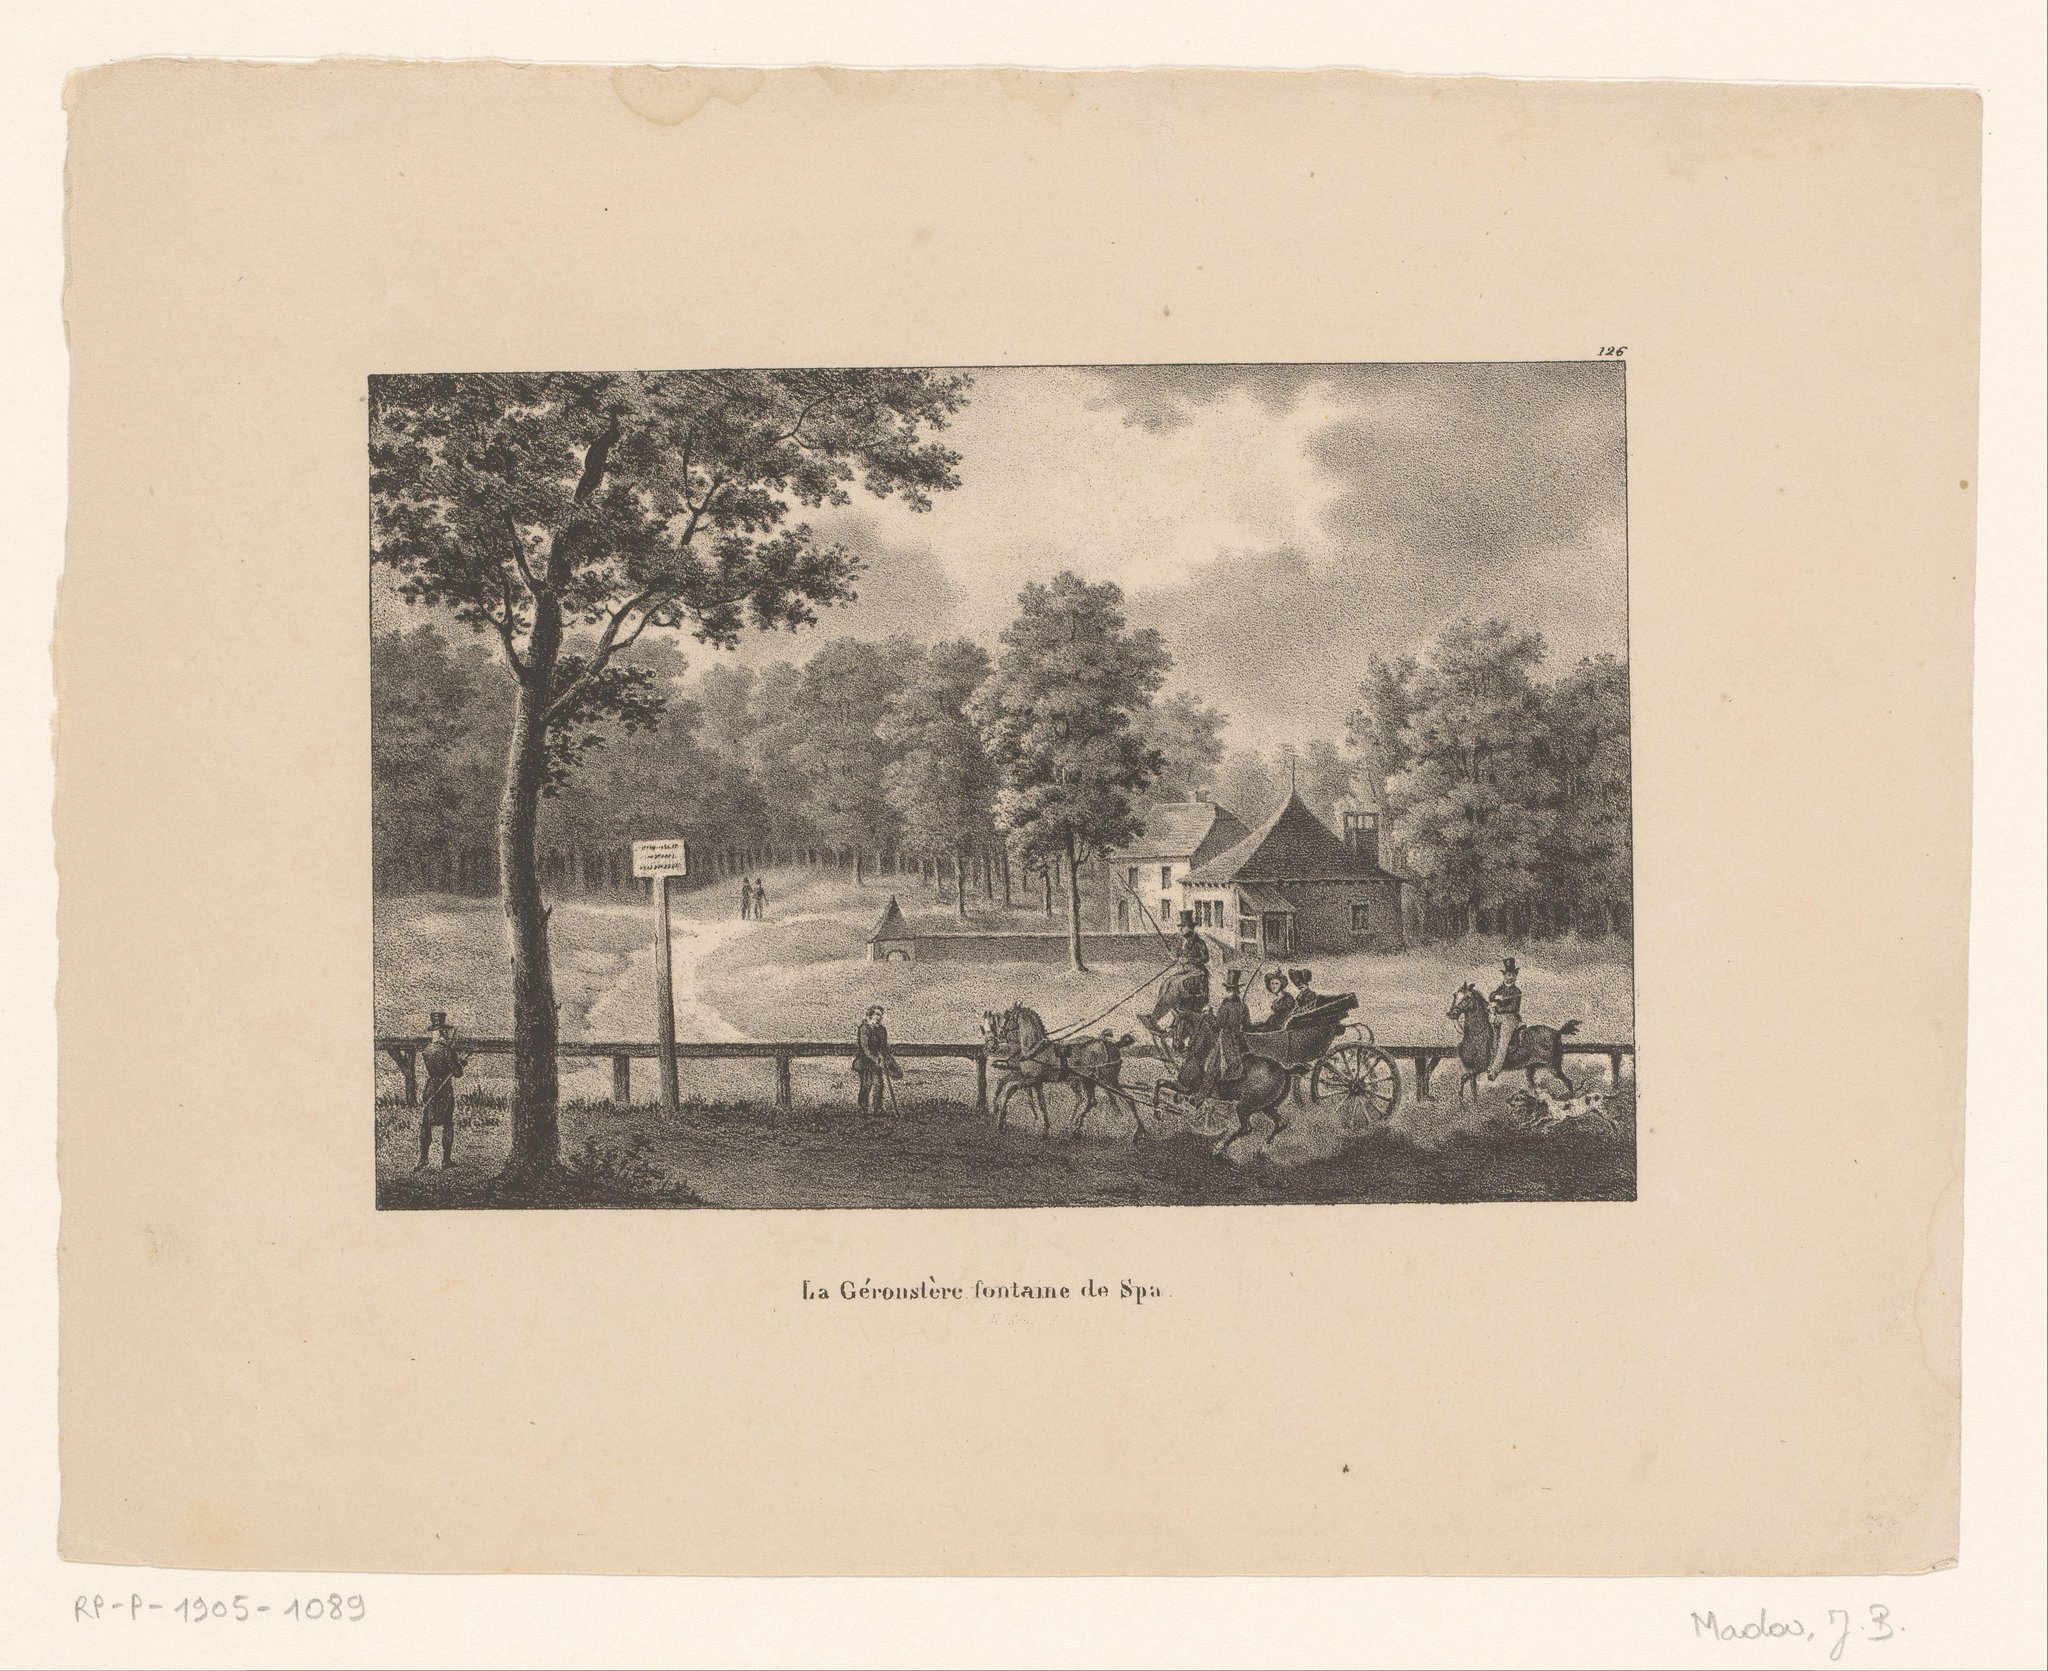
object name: book illustration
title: La Géronstère fontaine de Spa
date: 1822-1825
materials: paper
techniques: lithograph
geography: brussels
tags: mineral water, four-wheeled vehicle drawn by two animals, city-view, and landscape with man-made constructions (+ city(-scape) with figures, staffage)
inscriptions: collector's mark: Lugt 2228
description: Prent waarschijnlijk verschenen in: De Cloet, Jean. Voyage pittoresque dans le royaume des Pays Bas. Brussel: Jean Baptiste Ambroise Marcellin Jobard, 1825. Afleveringen voor deze publicatie verschijnen vanaf 1822. In 1825 zijn er onder deze titel twee banden vervaardigd. Wegens succes krijgt de publicatie een vervolg onder de titel 'Châteaux et monumens des Pays-Bas faisant suite au voyage pittoresque'.